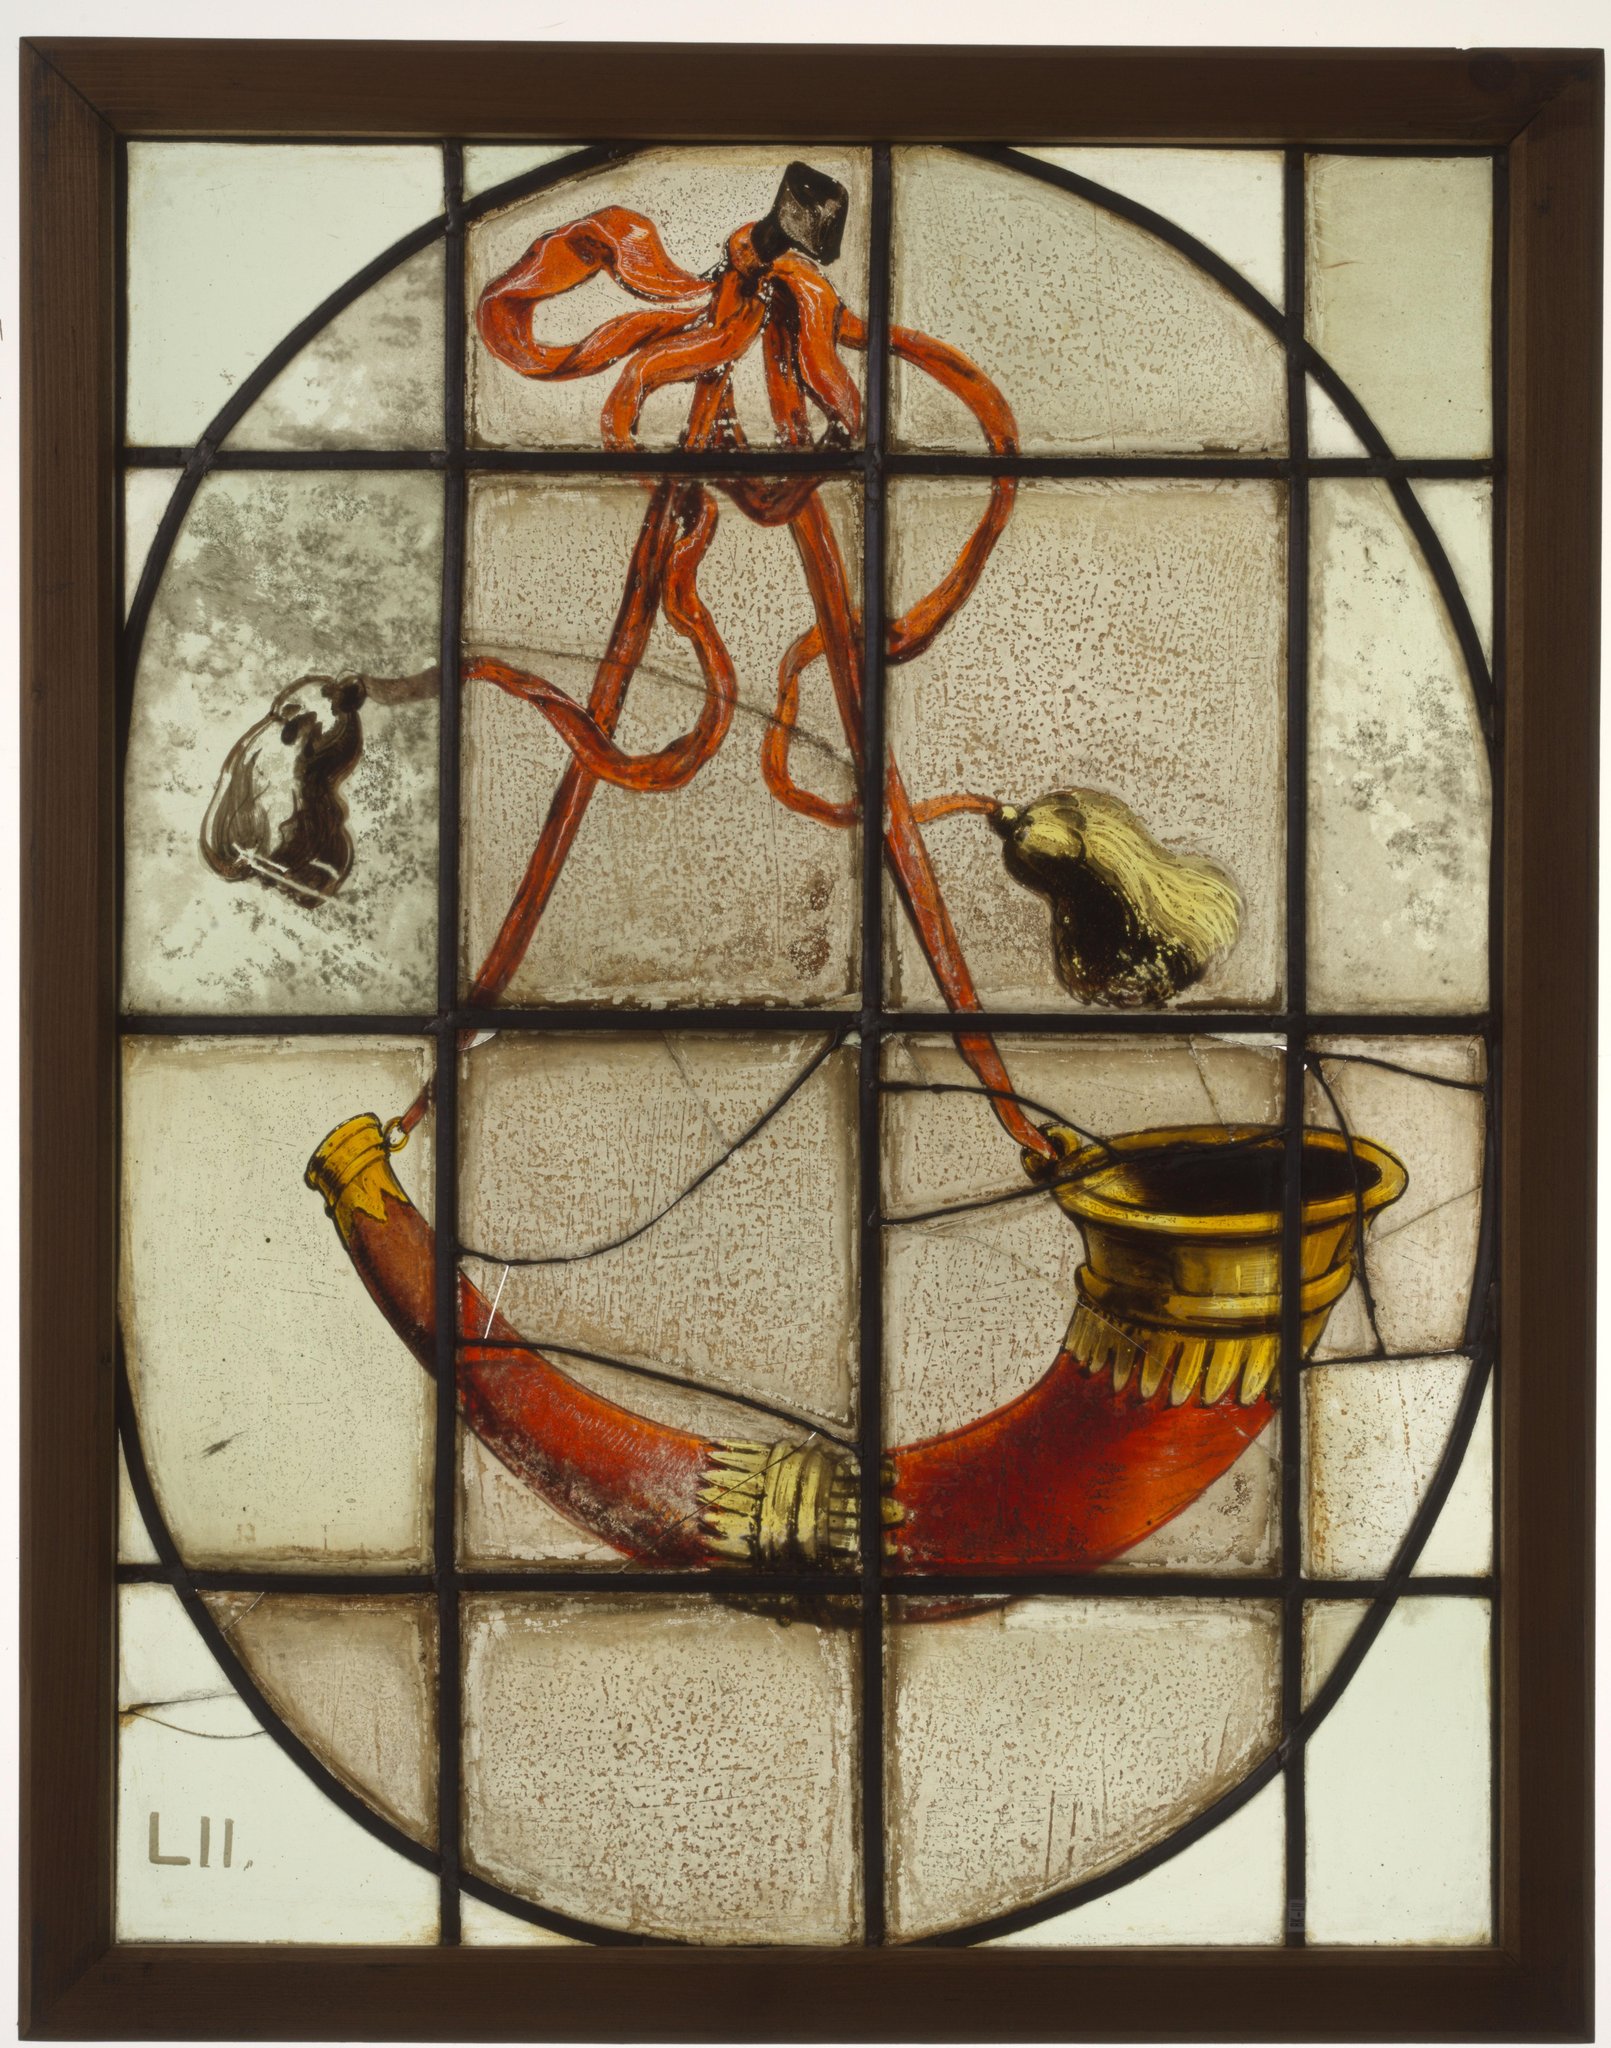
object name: light window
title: Ruit met rode hoorn met een koord aan een spijker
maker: Anonymous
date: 1600-1699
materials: glass, lead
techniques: leading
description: Ruit met in een ovaal een rode (post?)hoorn hangende met een koord aan een spijker.